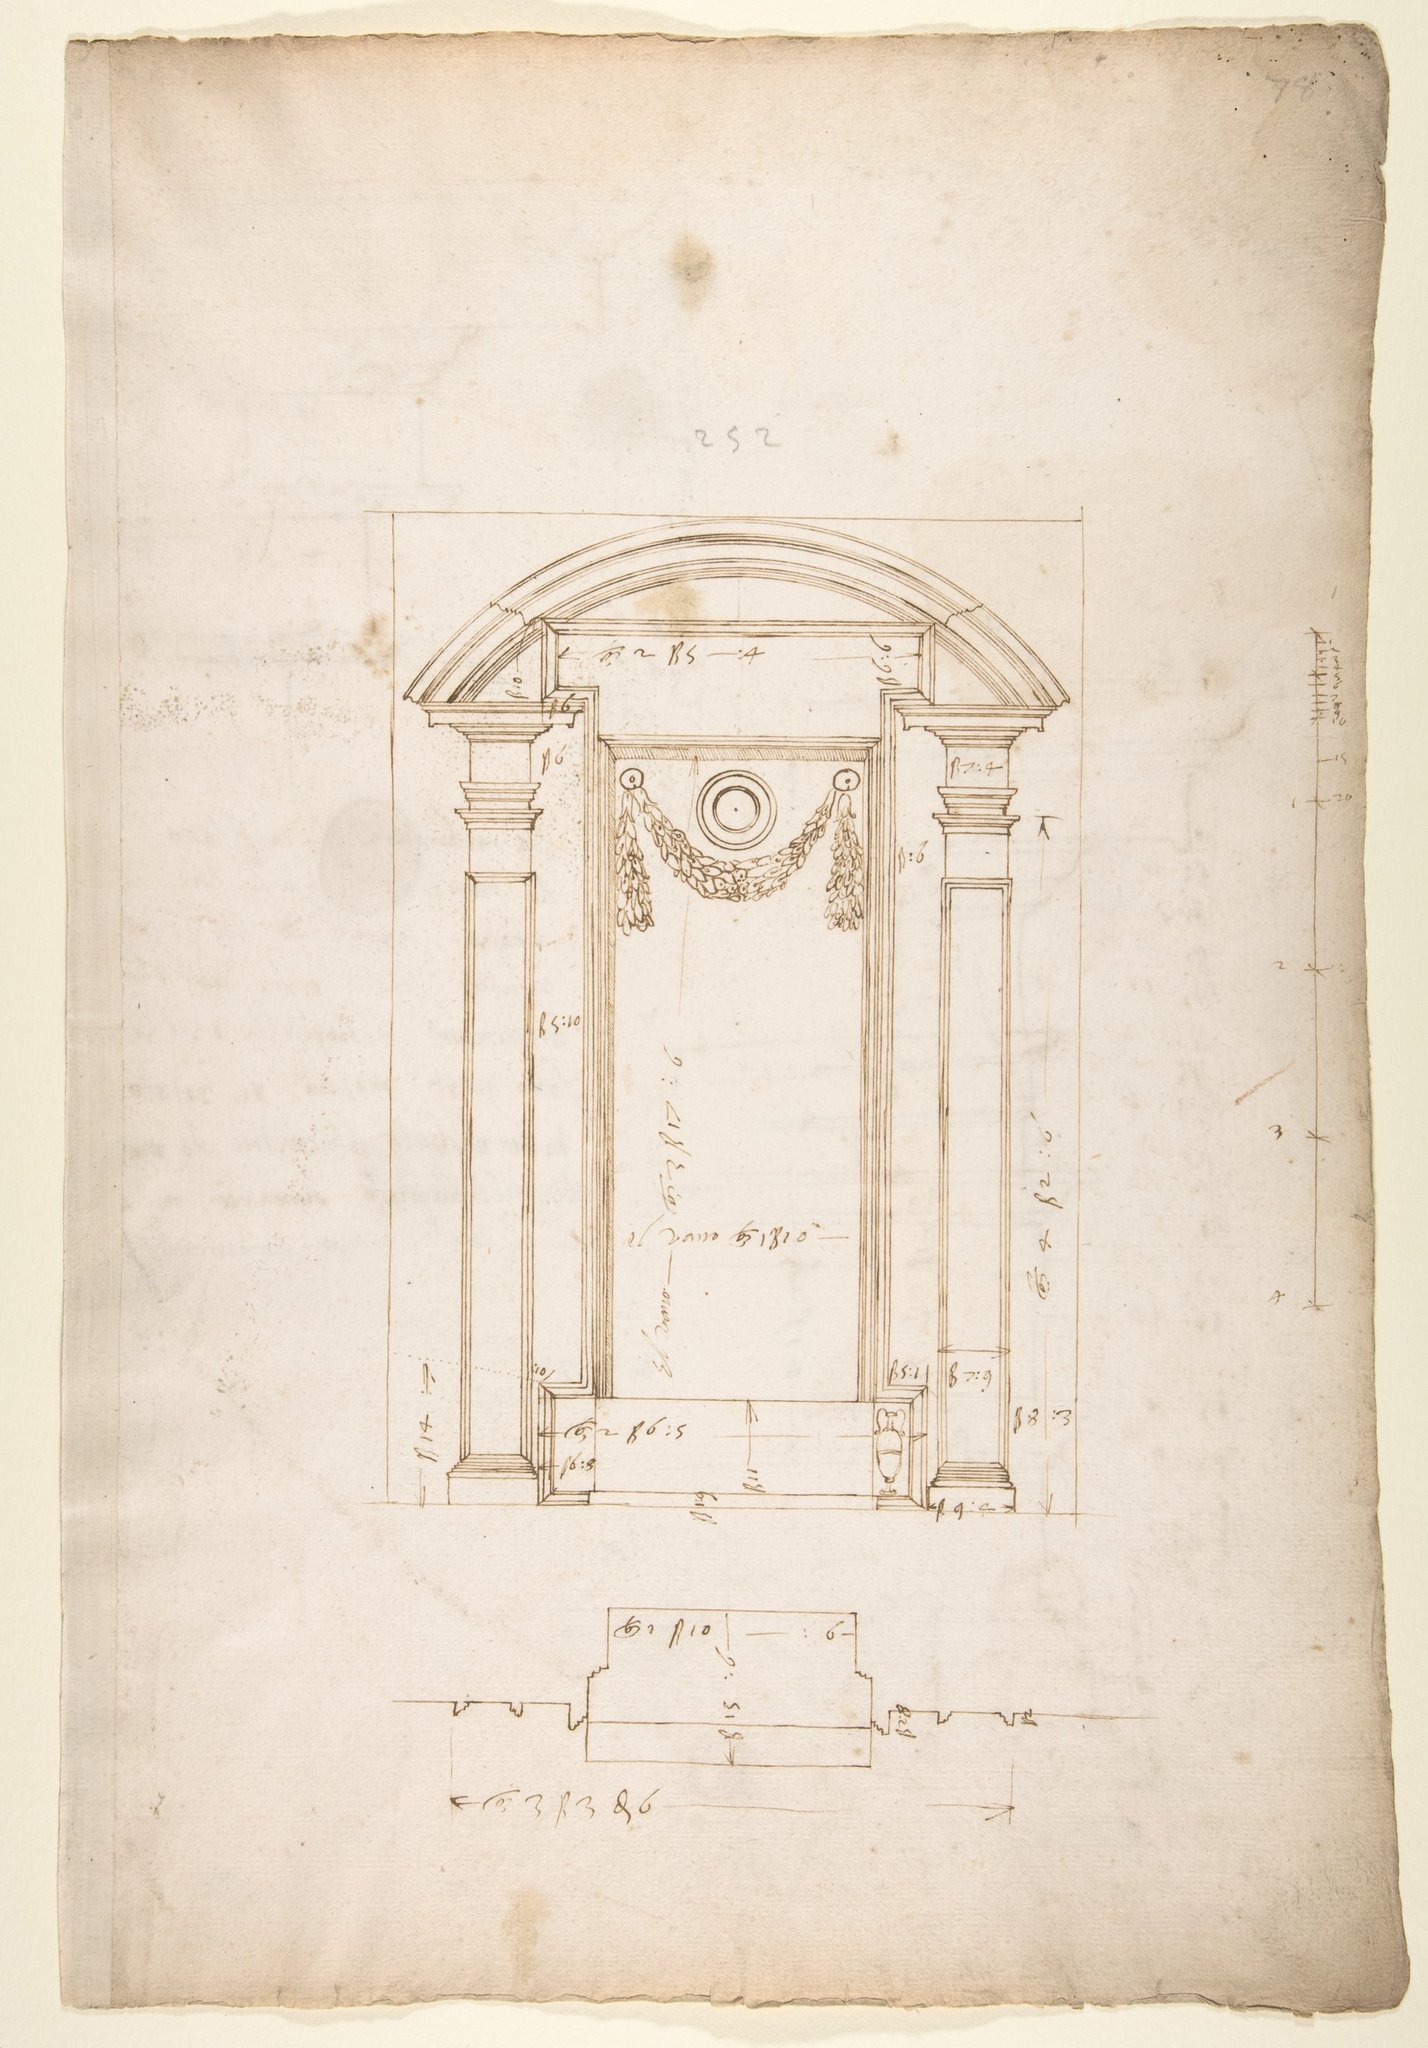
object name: drawing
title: San Lorenzo, New Sacristy, niche frame, tabernacle, plan and elevation (recto) San Lorenzo, New Sacristy, entablature, cornice, and base of niche, profiles (verso)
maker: anonymous, french, 16th century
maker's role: draftsman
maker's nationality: french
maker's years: 1500-1600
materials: chalk, ink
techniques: incising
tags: architecture